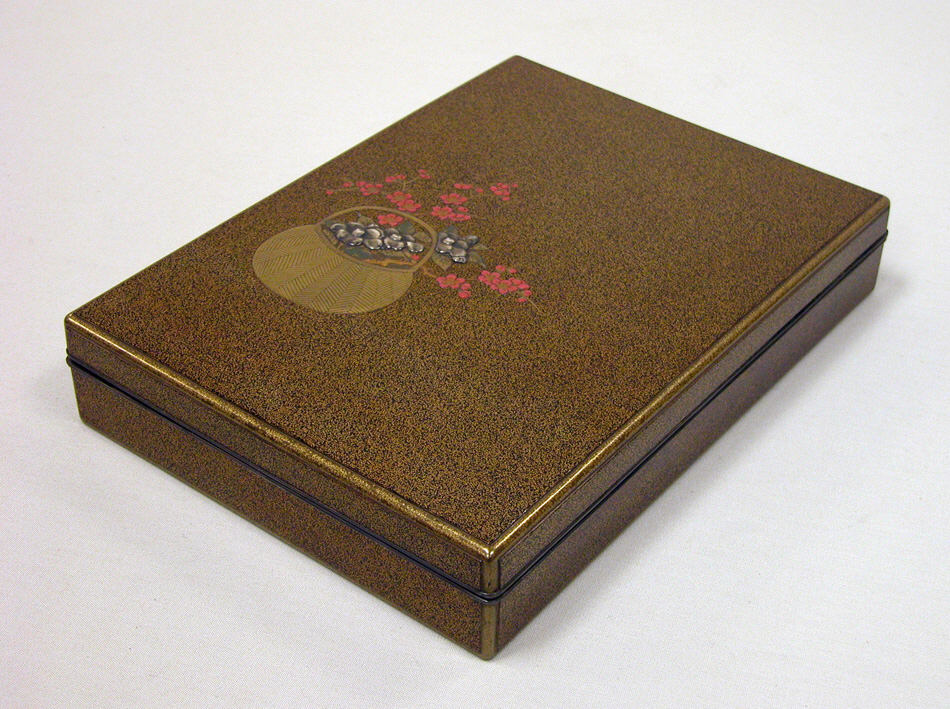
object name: writing box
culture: japanese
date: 1601-1700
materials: lacquer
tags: flowers